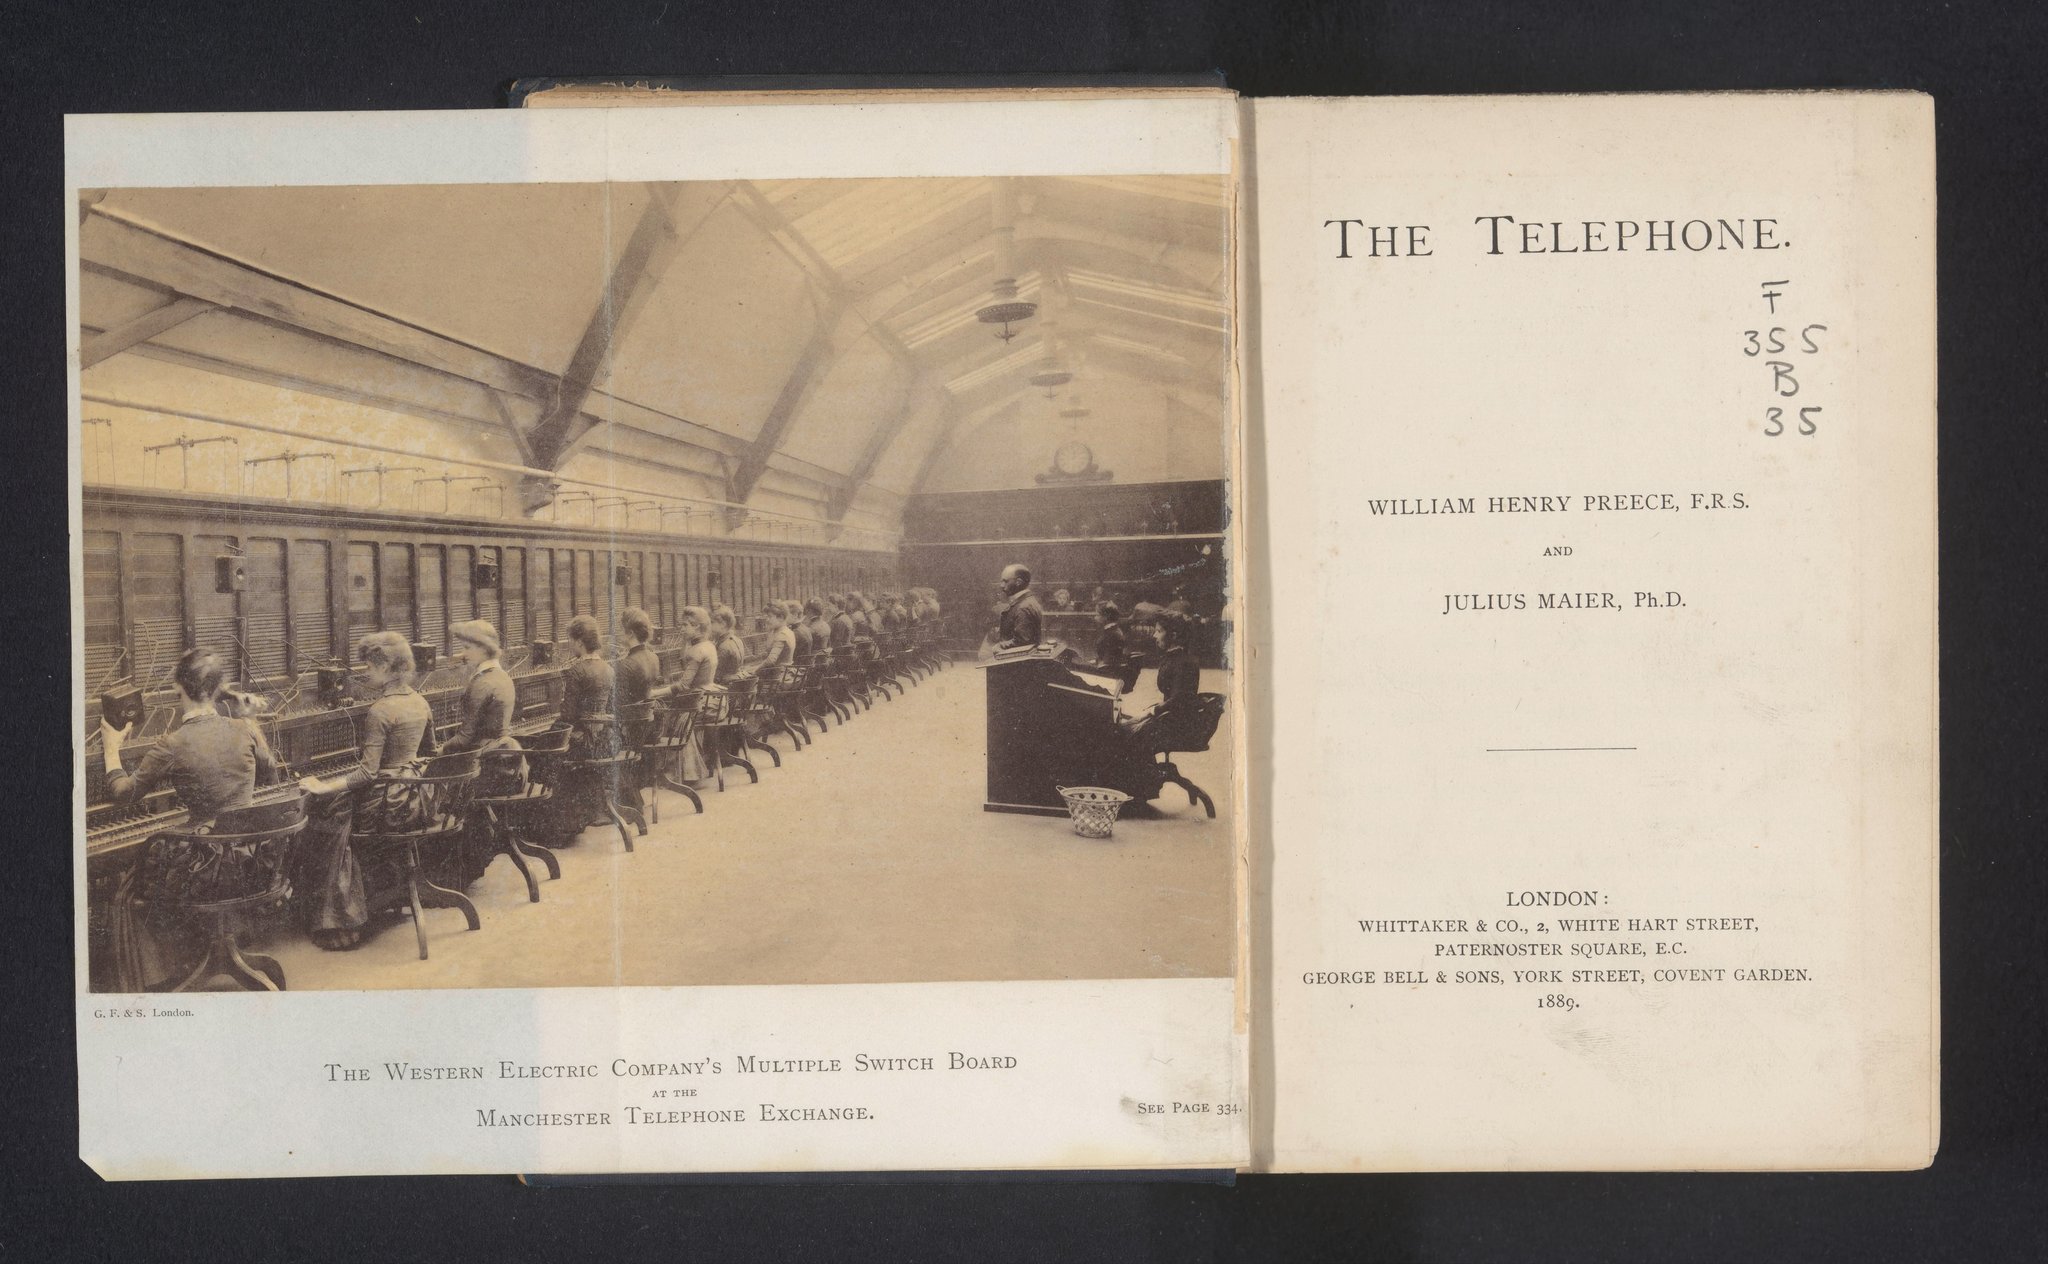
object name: page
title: The Western Electric Company's multiple switch board at the Manchester Telephone Exchange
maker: Anonymous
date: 1879-1889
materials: paper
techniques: photograph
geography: manchester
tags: telephone, exterior ~ representation of a building